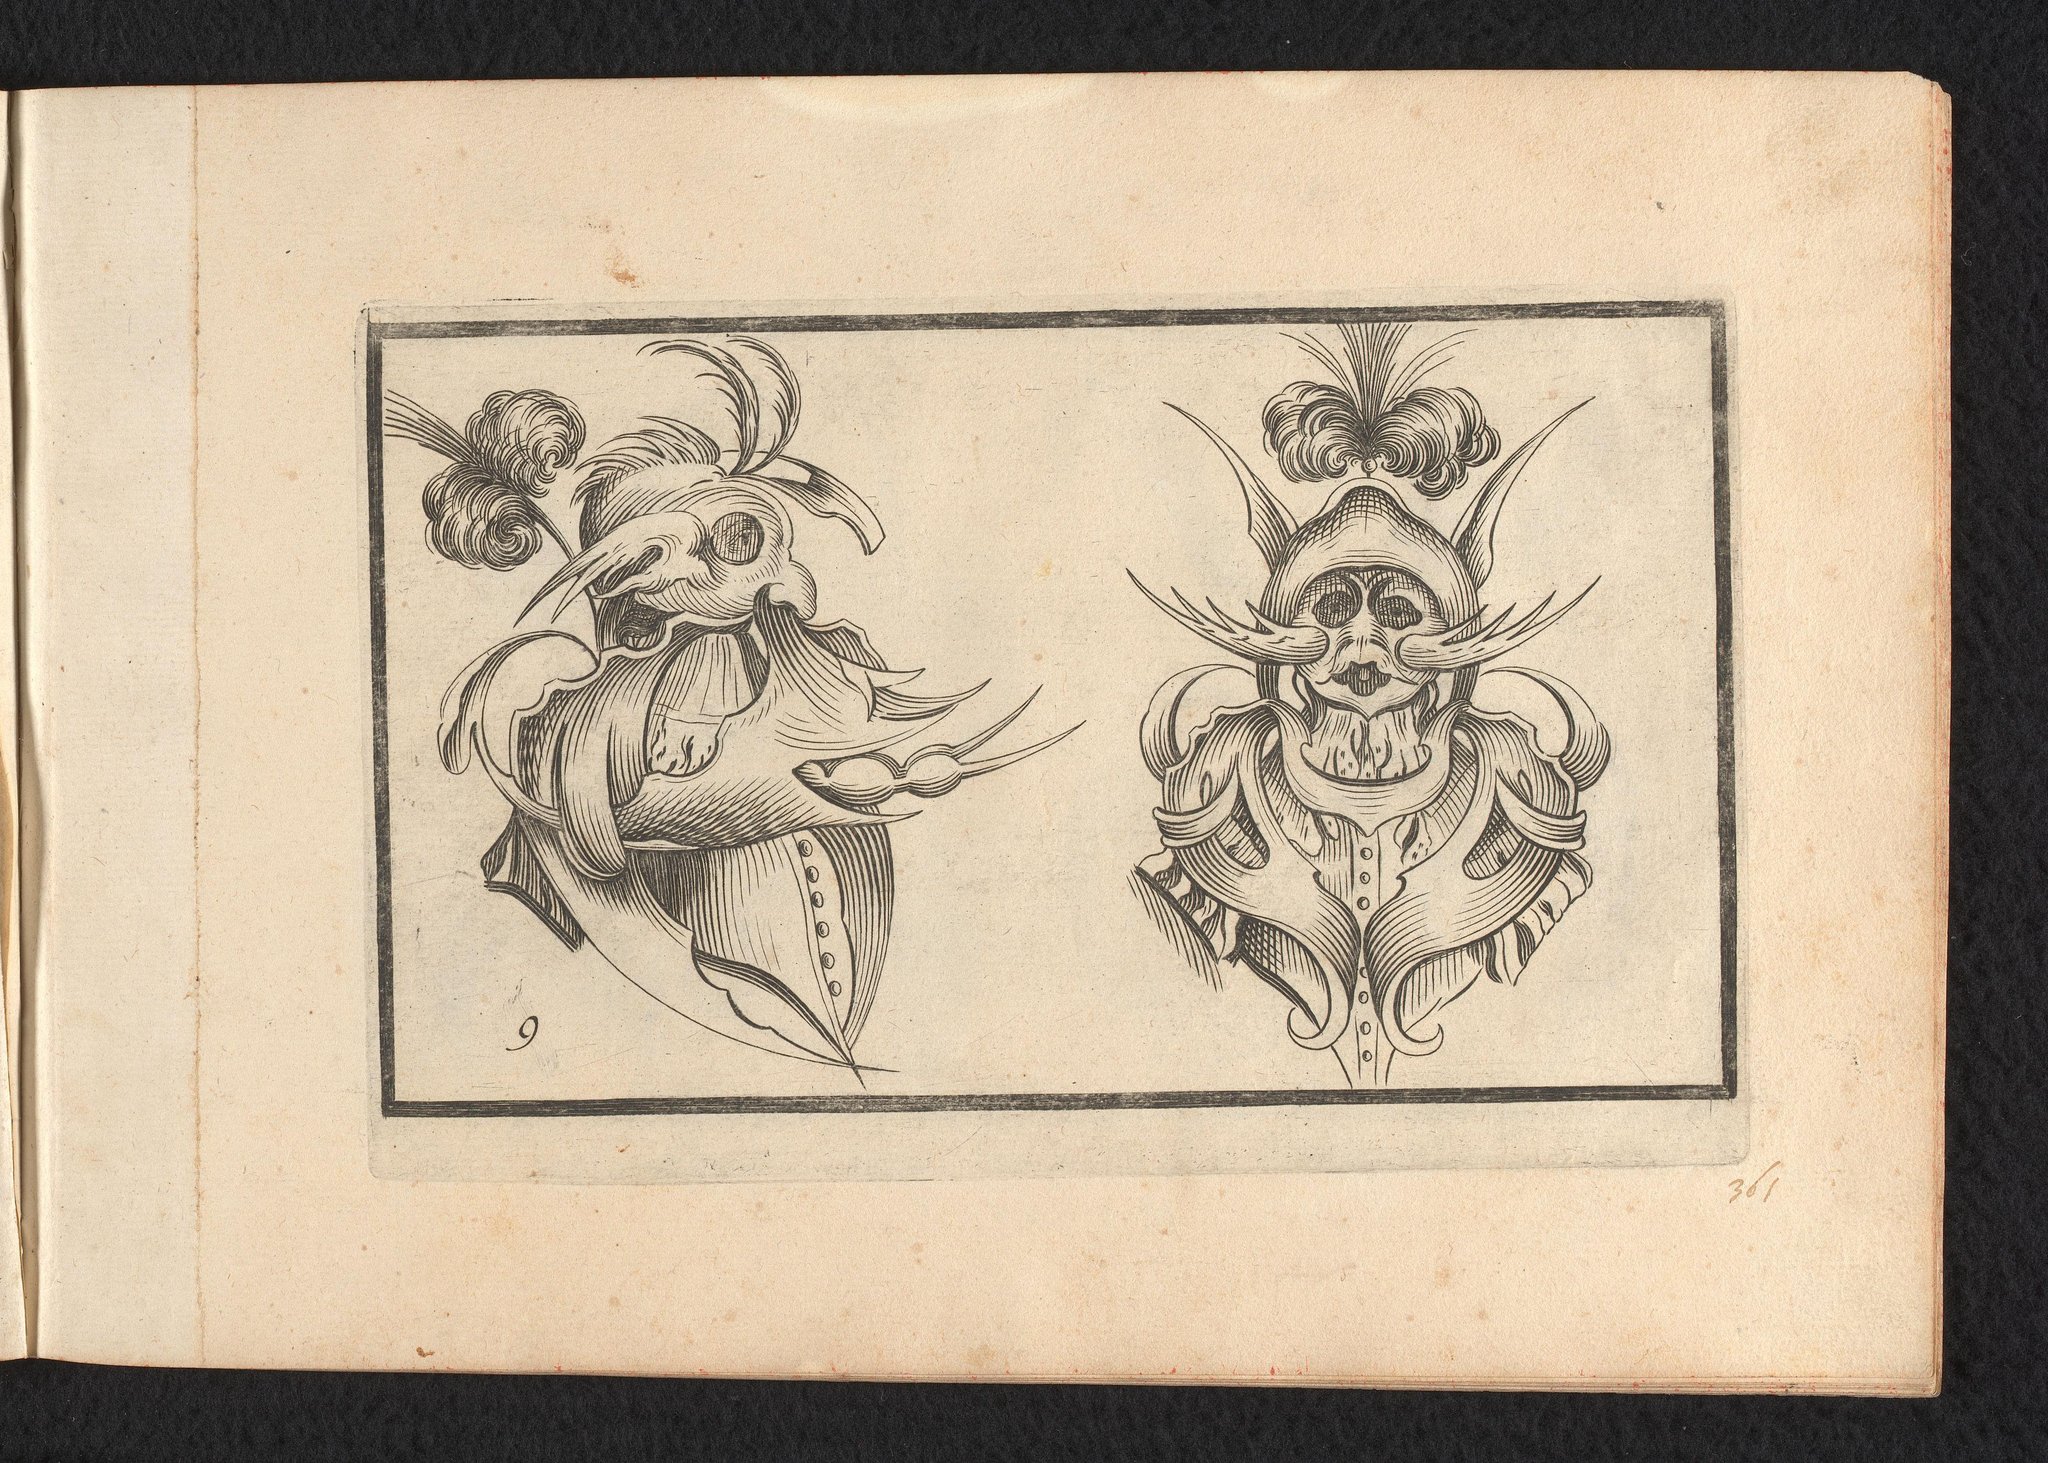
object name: print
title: Ouvrage rare et nouveau, contenant plusieurs desseins de merveilleuse recreation sous diverses caprices et gentillesses representees en l'industrieuse decoupure d'un chappeau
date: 1636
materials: paper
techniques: engraving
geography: paris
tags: ornaments ~ art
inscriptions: collector's mark: Lugt 2228, collector's mark: Lugt 2760, number: ‘361’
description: Deze prent maakt deel uit van een album.